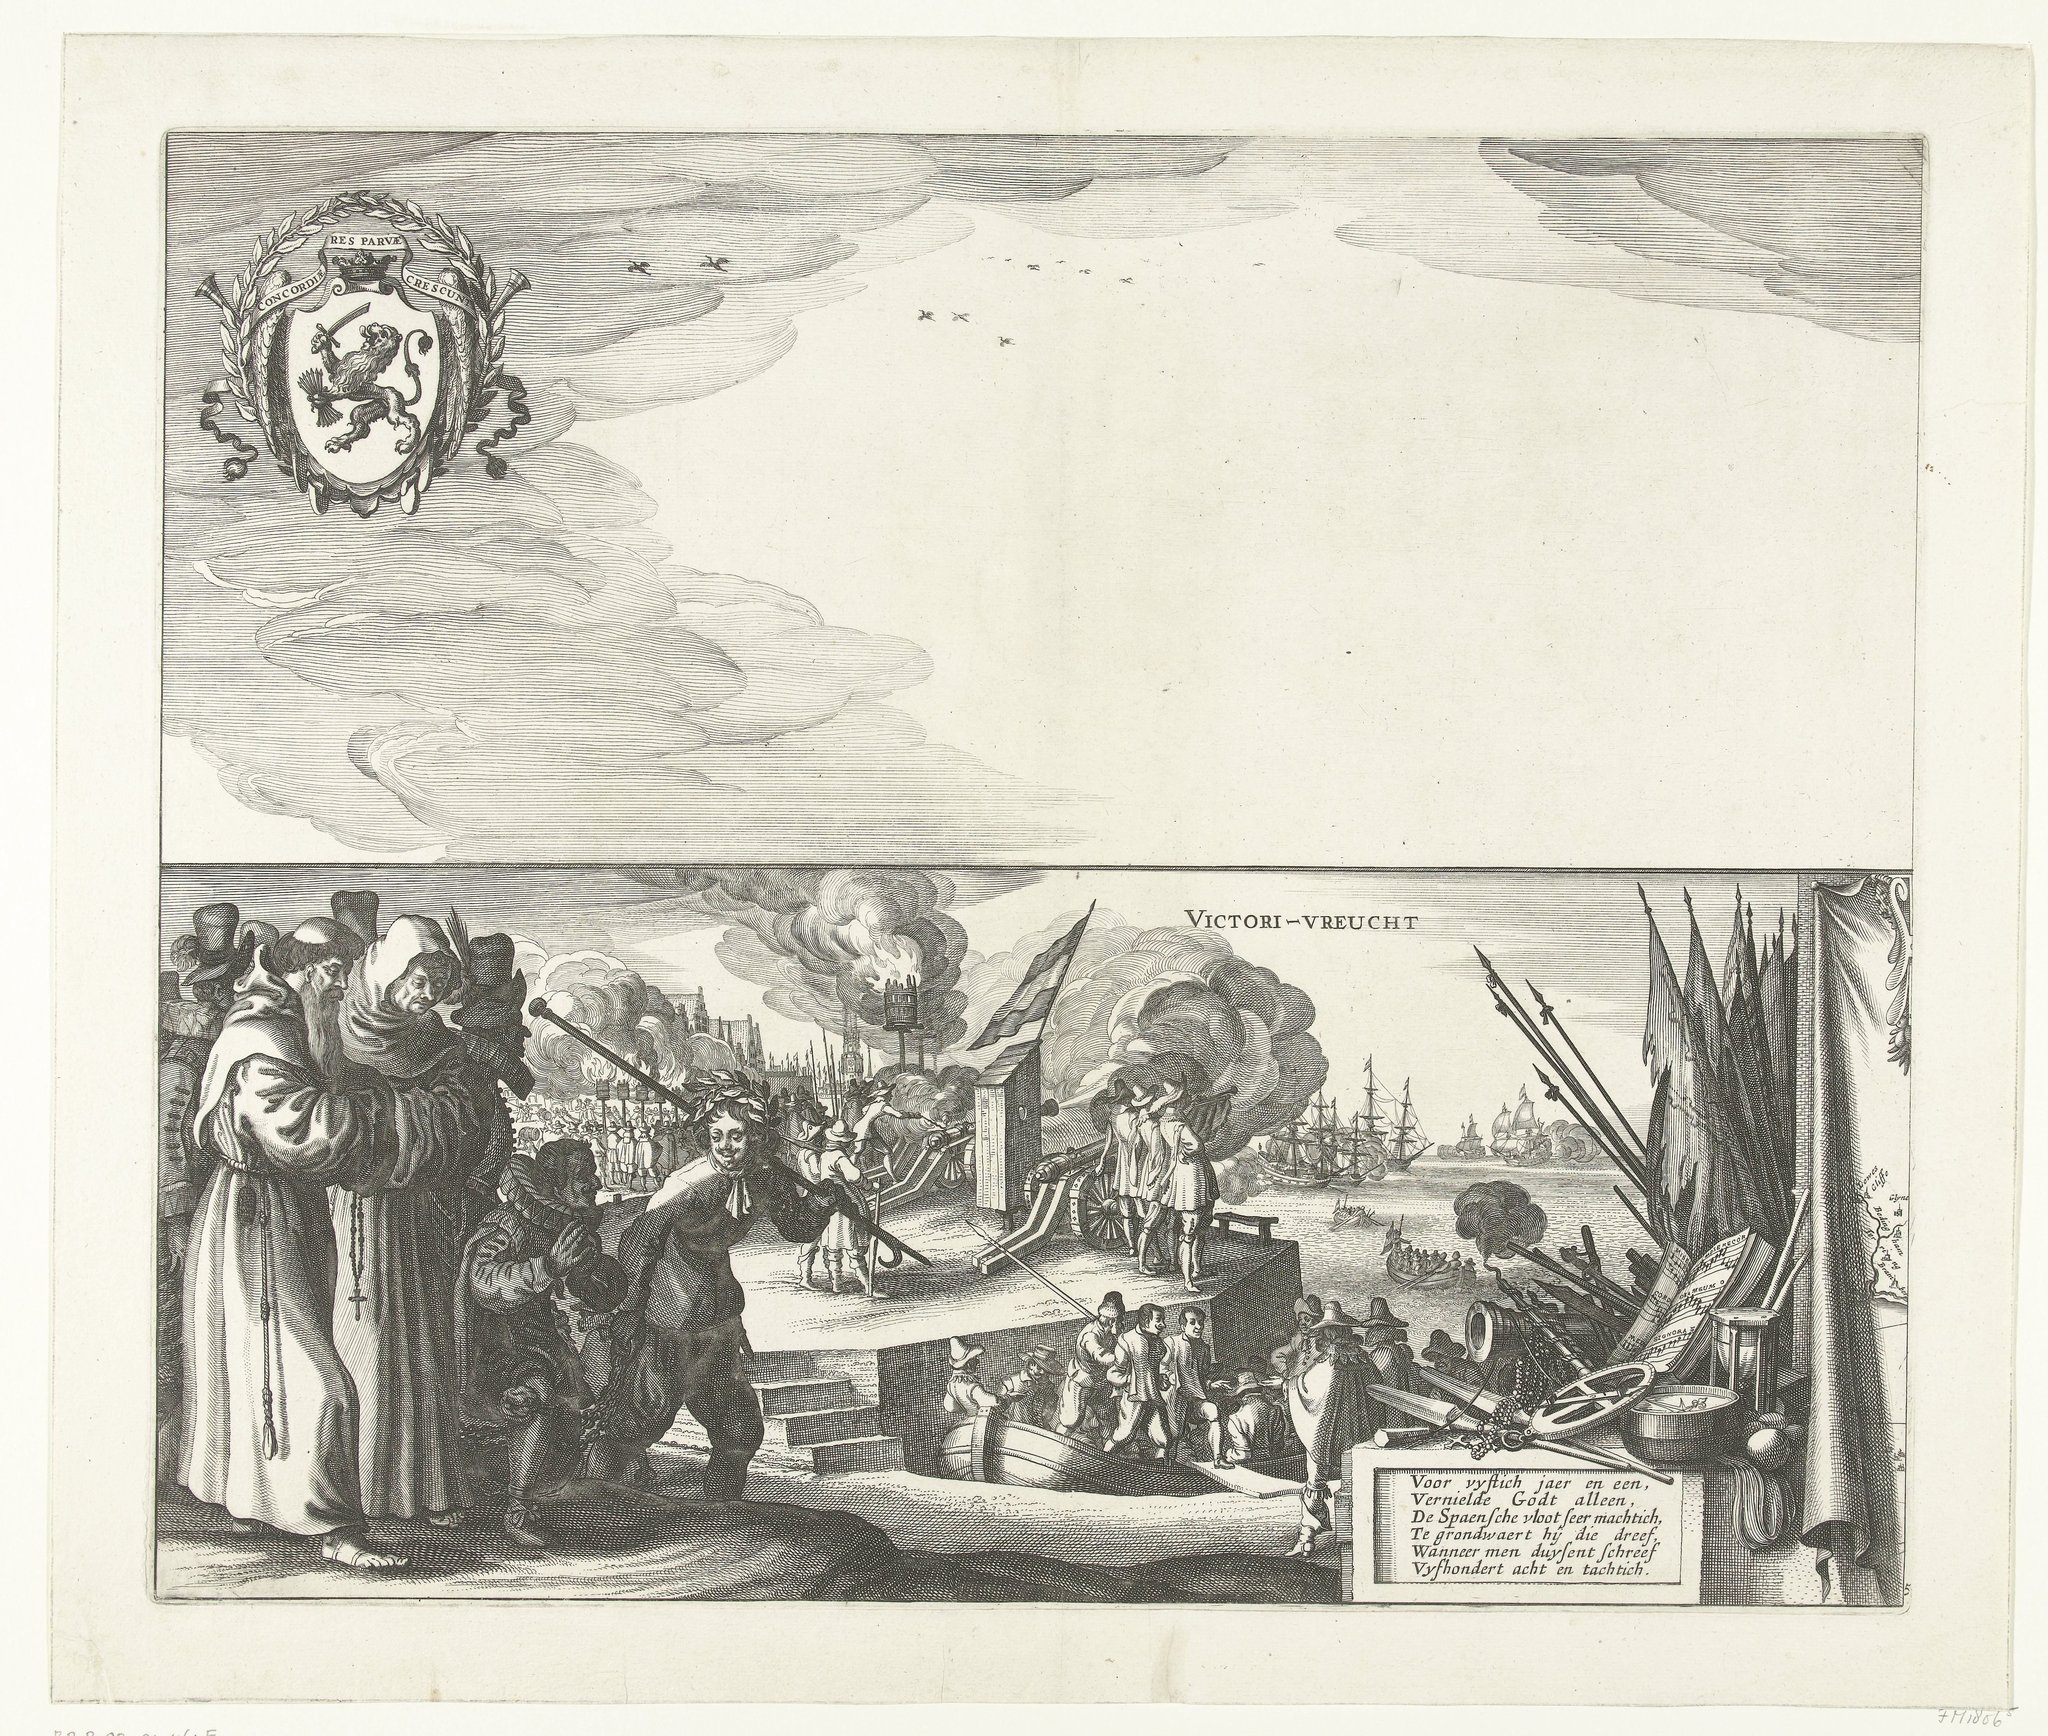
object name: print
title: Victori-vreucht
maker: claes jansz. visscher (ii)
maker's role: draughtsman, print maker, publisher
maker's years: 1586-1652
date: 1640-1643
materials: paper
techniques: engraving, etching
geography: amsterdam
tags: brielle, maarten harpertszoon tromp, bonfire, fire-works, prisoner of war (after the battle), battle of the downs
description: Grote voorstelling van de zeeslag bij Duins tussen de Spaanse vloot onder bevel van Antonio de Oquendo en de Staatse vloot onder Maarten Harpertsz. Tromp, 21 oktober 1639. Blad 5: voorstelling in tweeën gedeeld. Bovenaan de lucht met het wapen van de Generaliteit. Daaronder geketende gevangen Spanjaarden en monniken aan de wal, saluutschoten en vreugdevuren bij de viering van de overwinning in de slag bij Duins. Rechts een cartouche met een vers van 6 regels in het Nederlands waarin een vergelijking wordt gemaakt met de ondergang van de Armada in 1588. Ongemonteerde ensemble bestaande uit 7 genummerde platen, de zwarte stroken met de titel en tekstblad met de beschrijving.